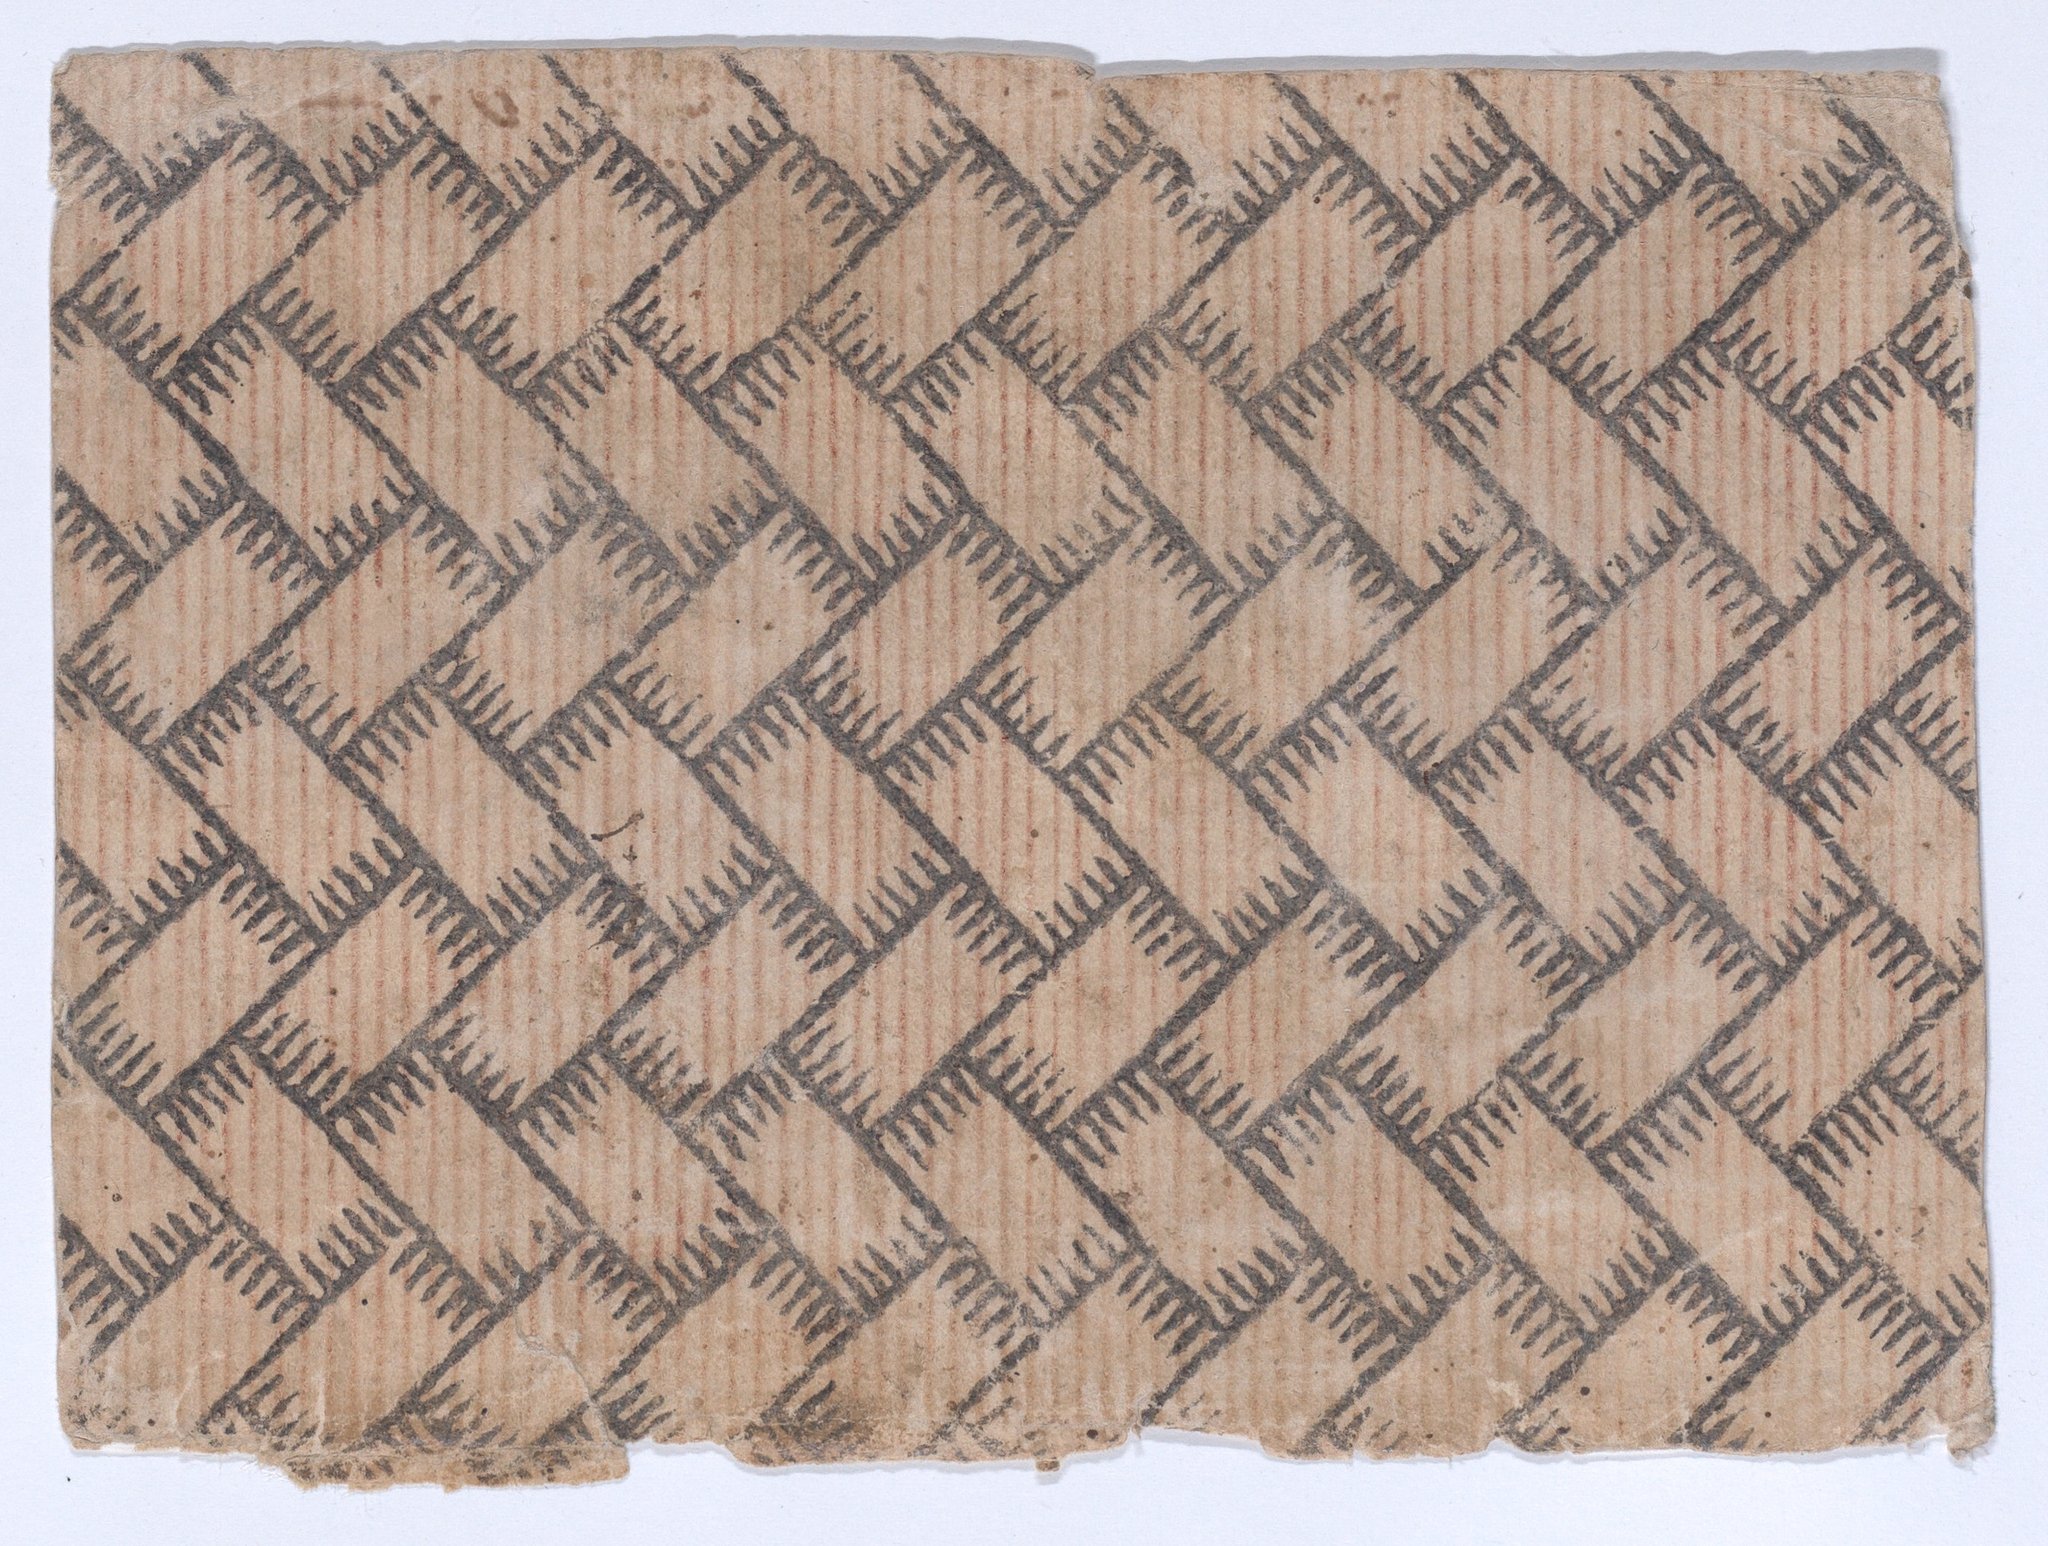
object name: print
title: Sheet with an overall geometric pattern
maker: Anonymous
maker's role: artist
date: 1801-1900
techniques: relief print